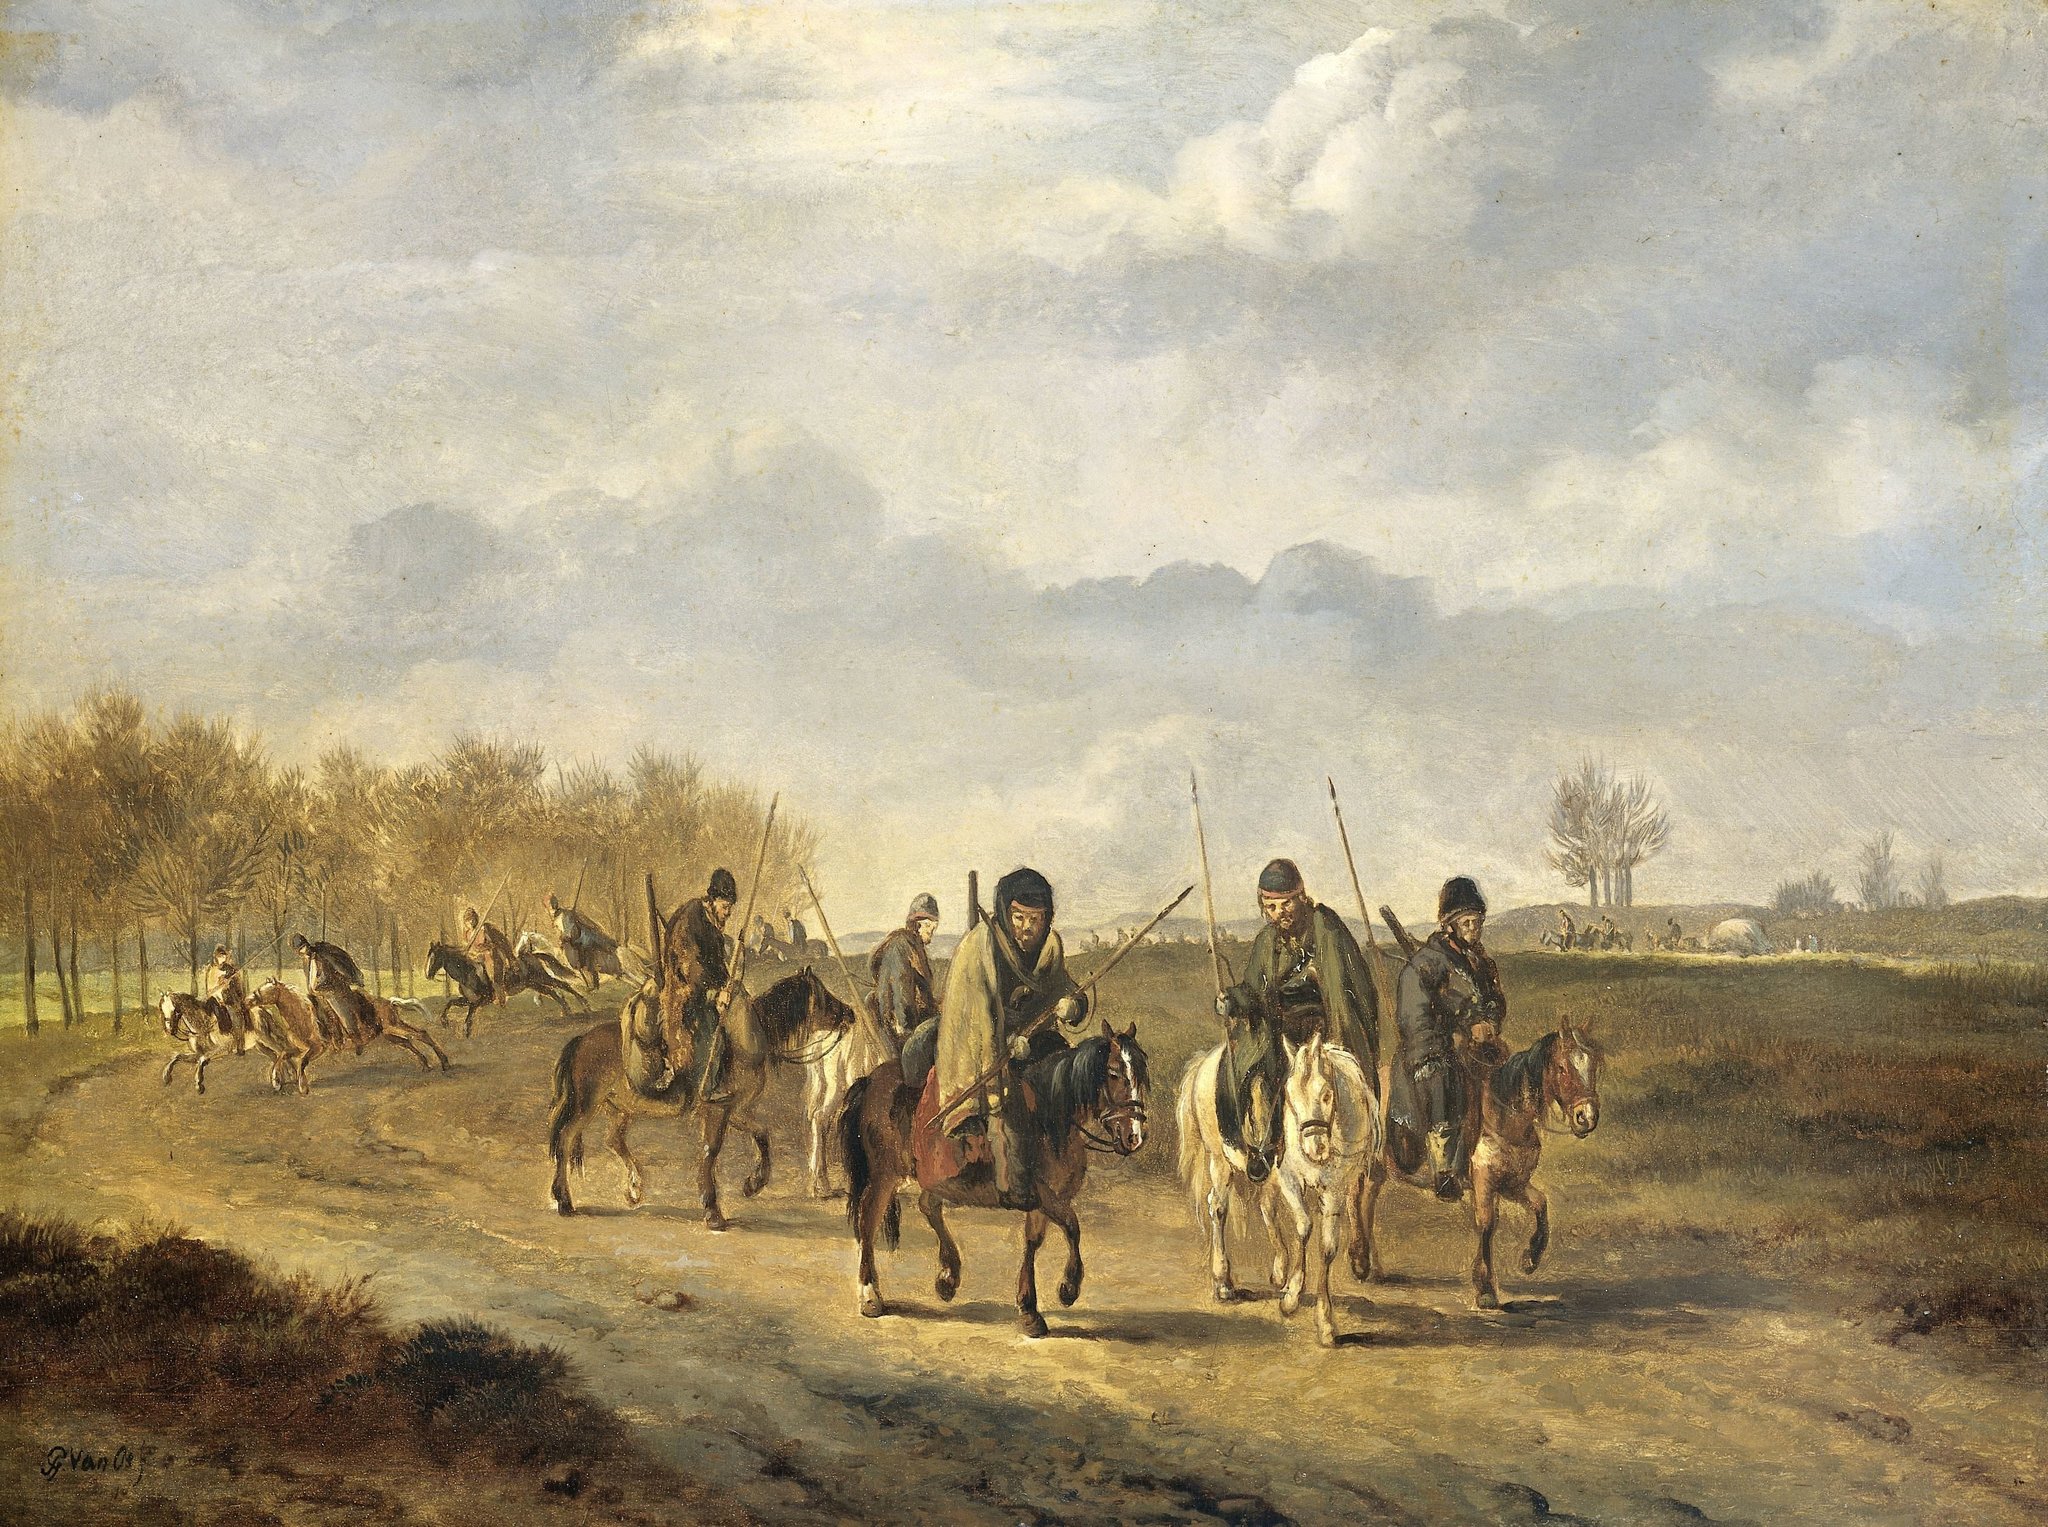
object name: painting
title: Cossacks on a country Road near Bergen in North Holland, 1813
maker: pieter gerardus van os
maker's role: draughtsman, painter, print maker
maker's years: 1776-1839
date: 1813-1815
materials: oil, panel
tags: troop movements, transportation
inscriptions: signature: ‘PG Van Os fe’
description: Kozakken op een landweg bij Bergen in Noord-Holland, 1813. Bewapende soldaten te paard in een lange stoet over een zandweg.